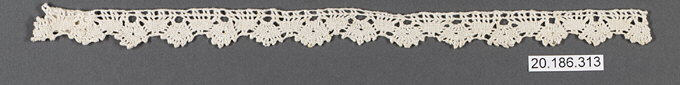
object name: edging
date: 1601-1700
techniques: lace